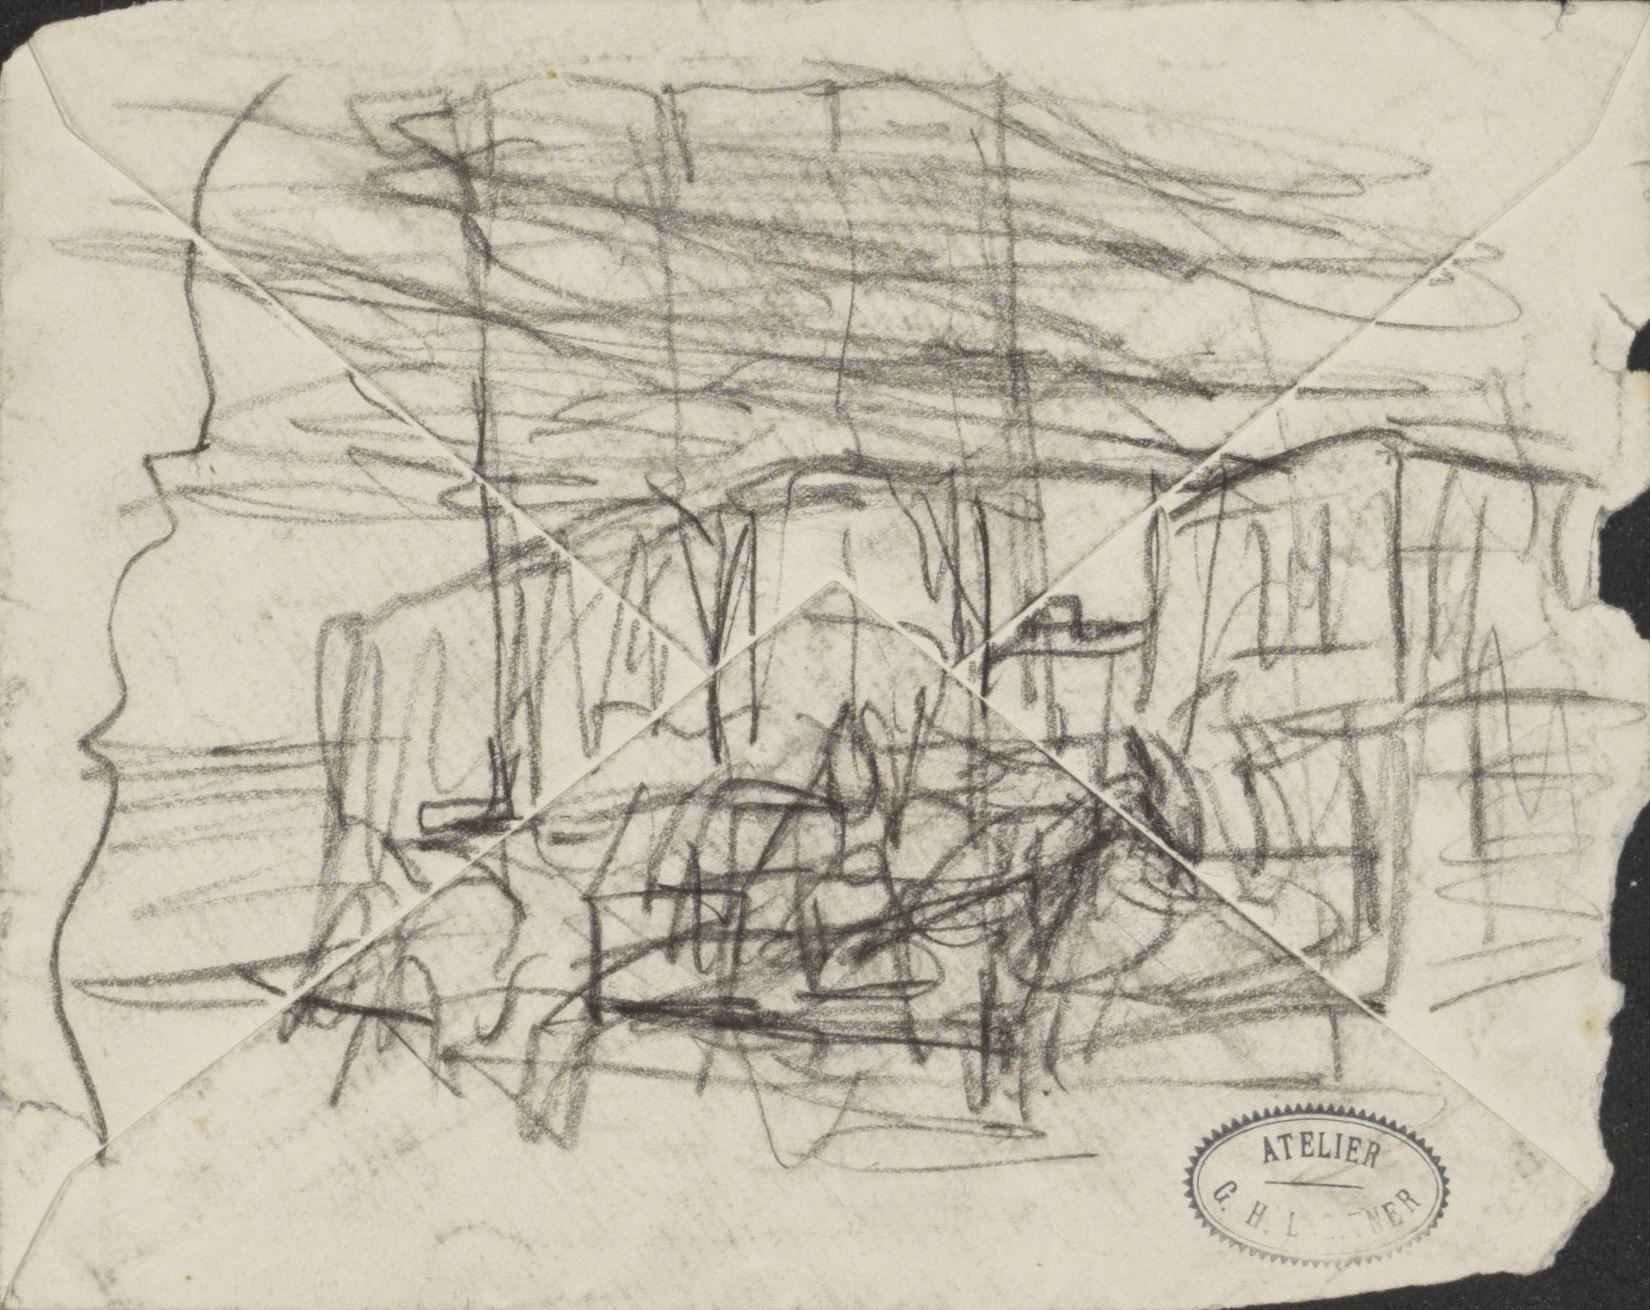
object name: drawing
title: Paardentrams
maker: george hendrik breitner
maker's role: draughtsman, painter, print maker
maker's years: 1857-1923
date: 1886-1923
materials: chalk, paper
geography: amsterdam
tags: diligence, omnibus, horse-tram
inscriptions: collector's mark: Lugt 2228, workshop stamp: Lugt 291d